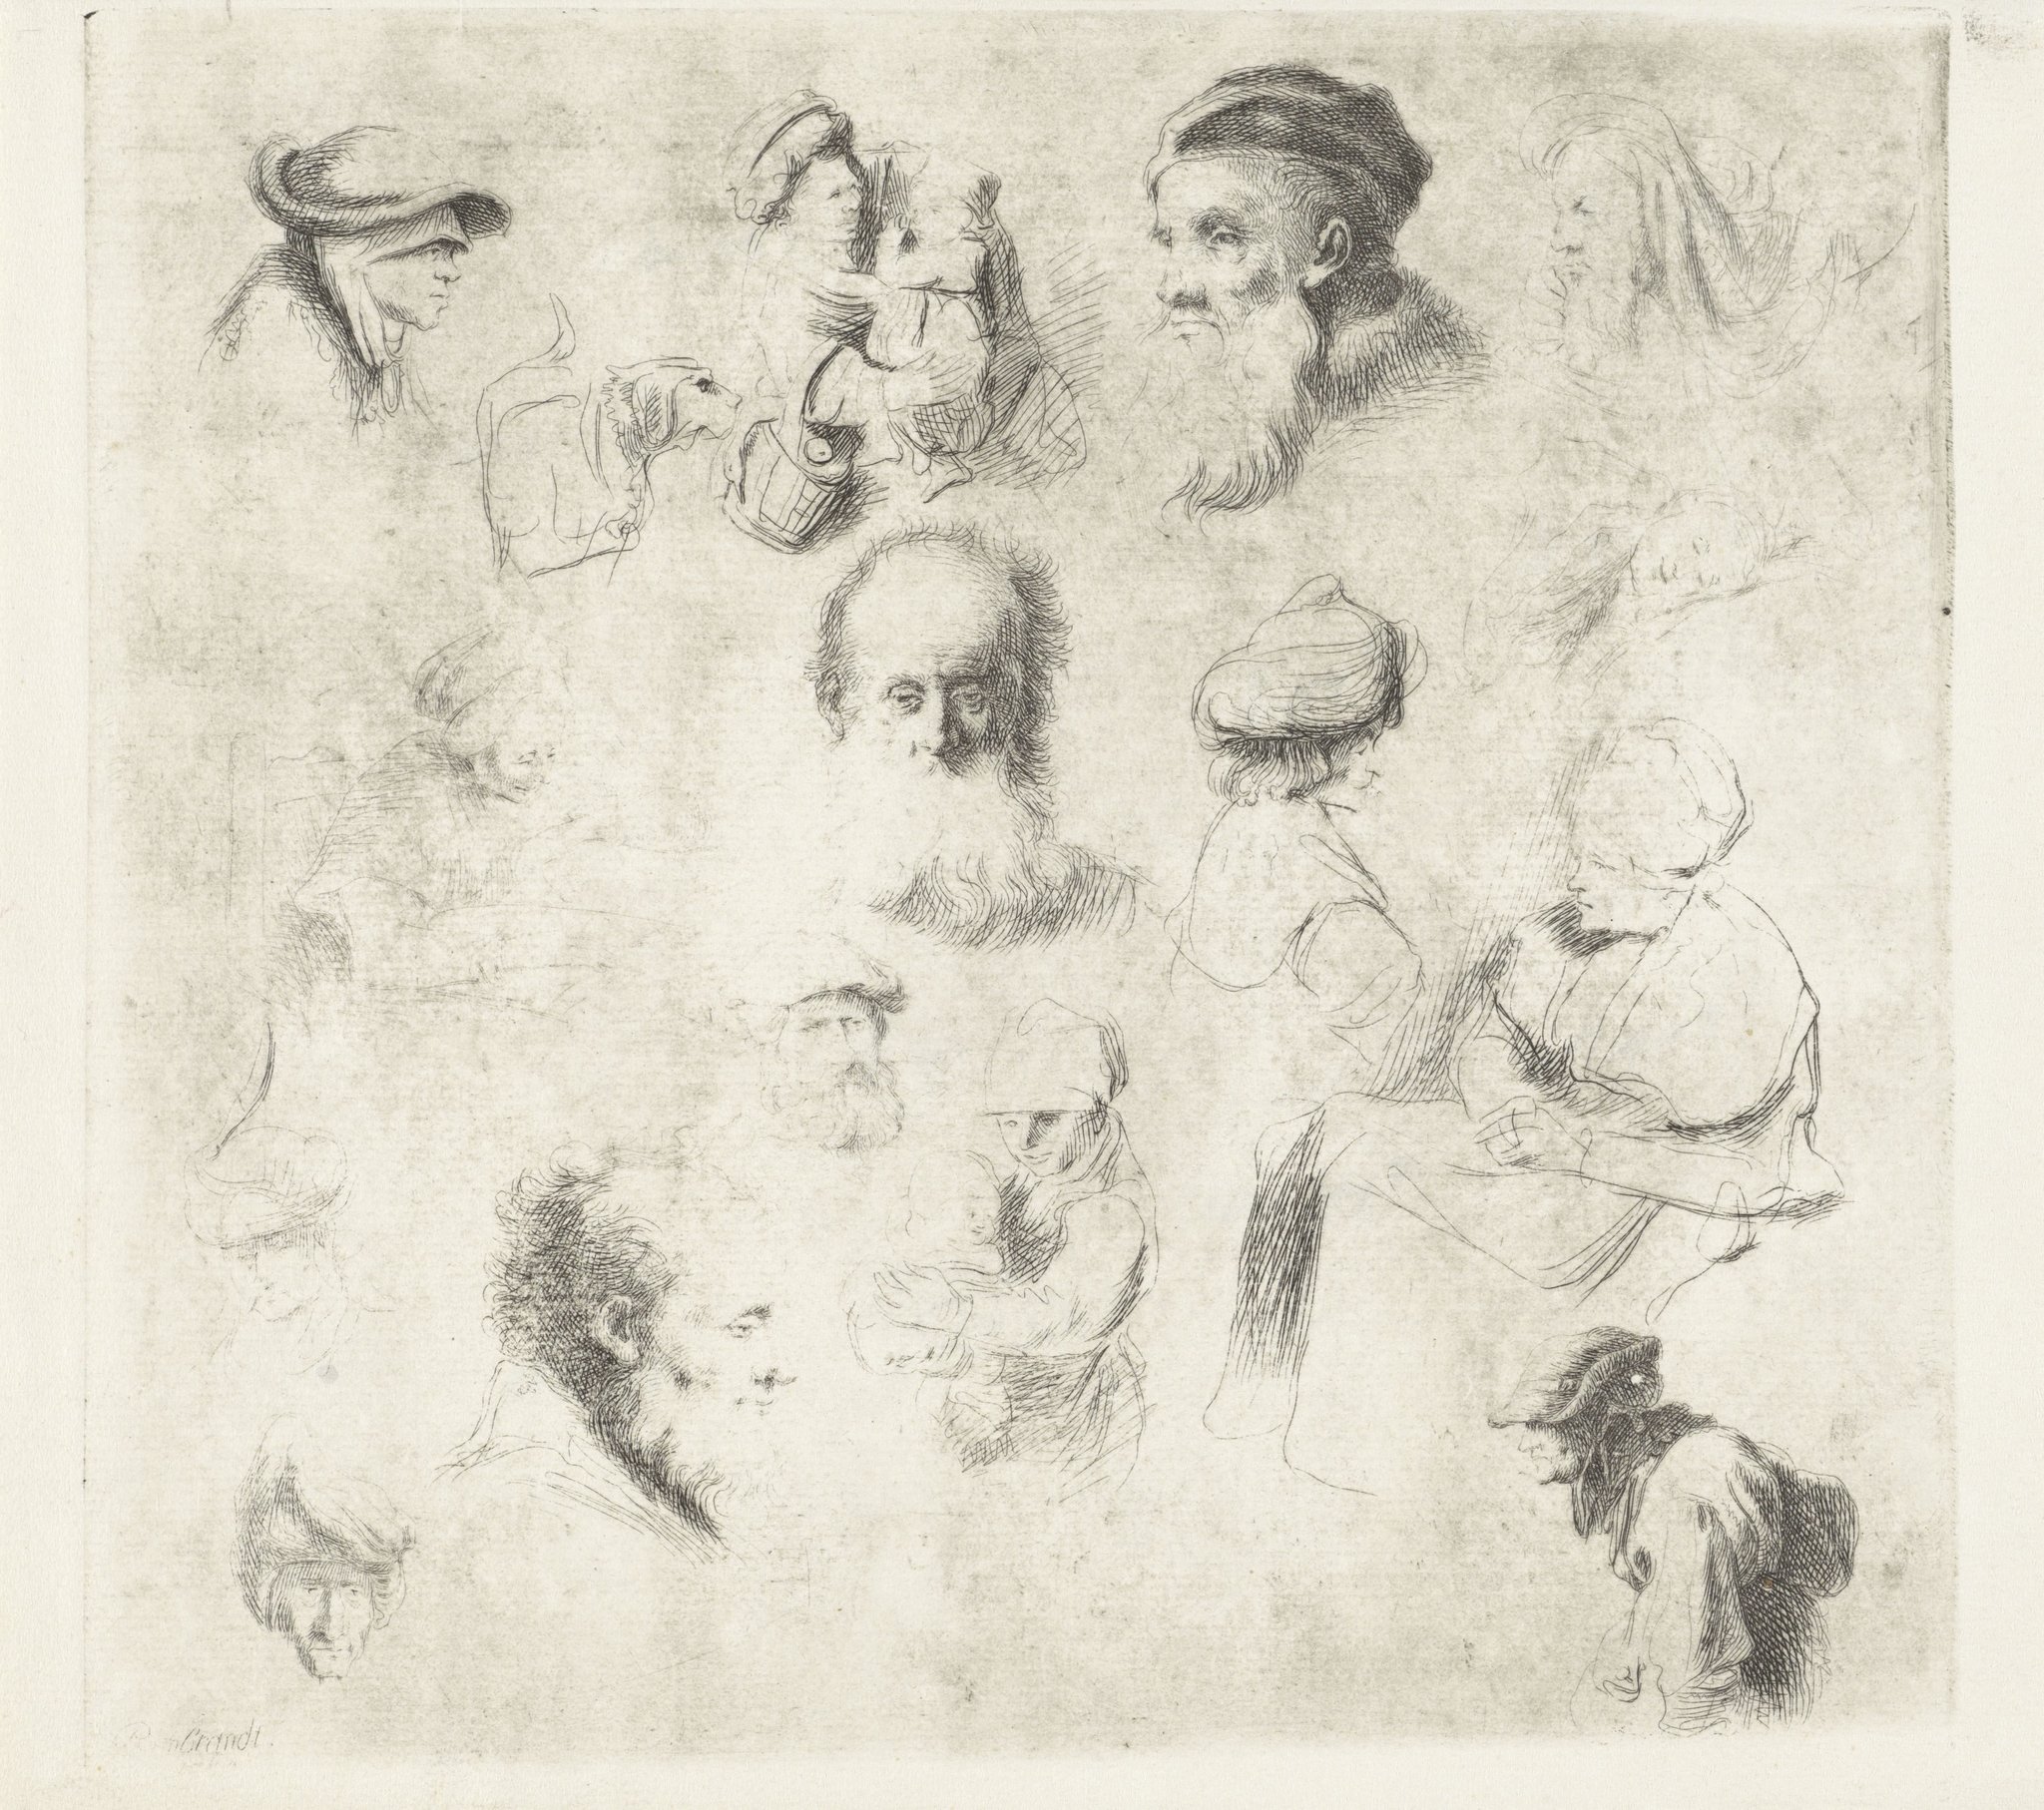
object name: print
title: Studies van hoofden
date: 1625-1719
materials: paper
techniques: etching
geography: low countries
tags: head (human), mother and child(ren), woman and child(ren) (family group), dog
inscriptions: collector's mark: Lugt 2228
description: Studies van hoofden van mannen en vrouwen in verschillende leeftijdscategorieën en in verschillende aanzichten. Ook twee studies van een vrouw met een baby op haar arm.